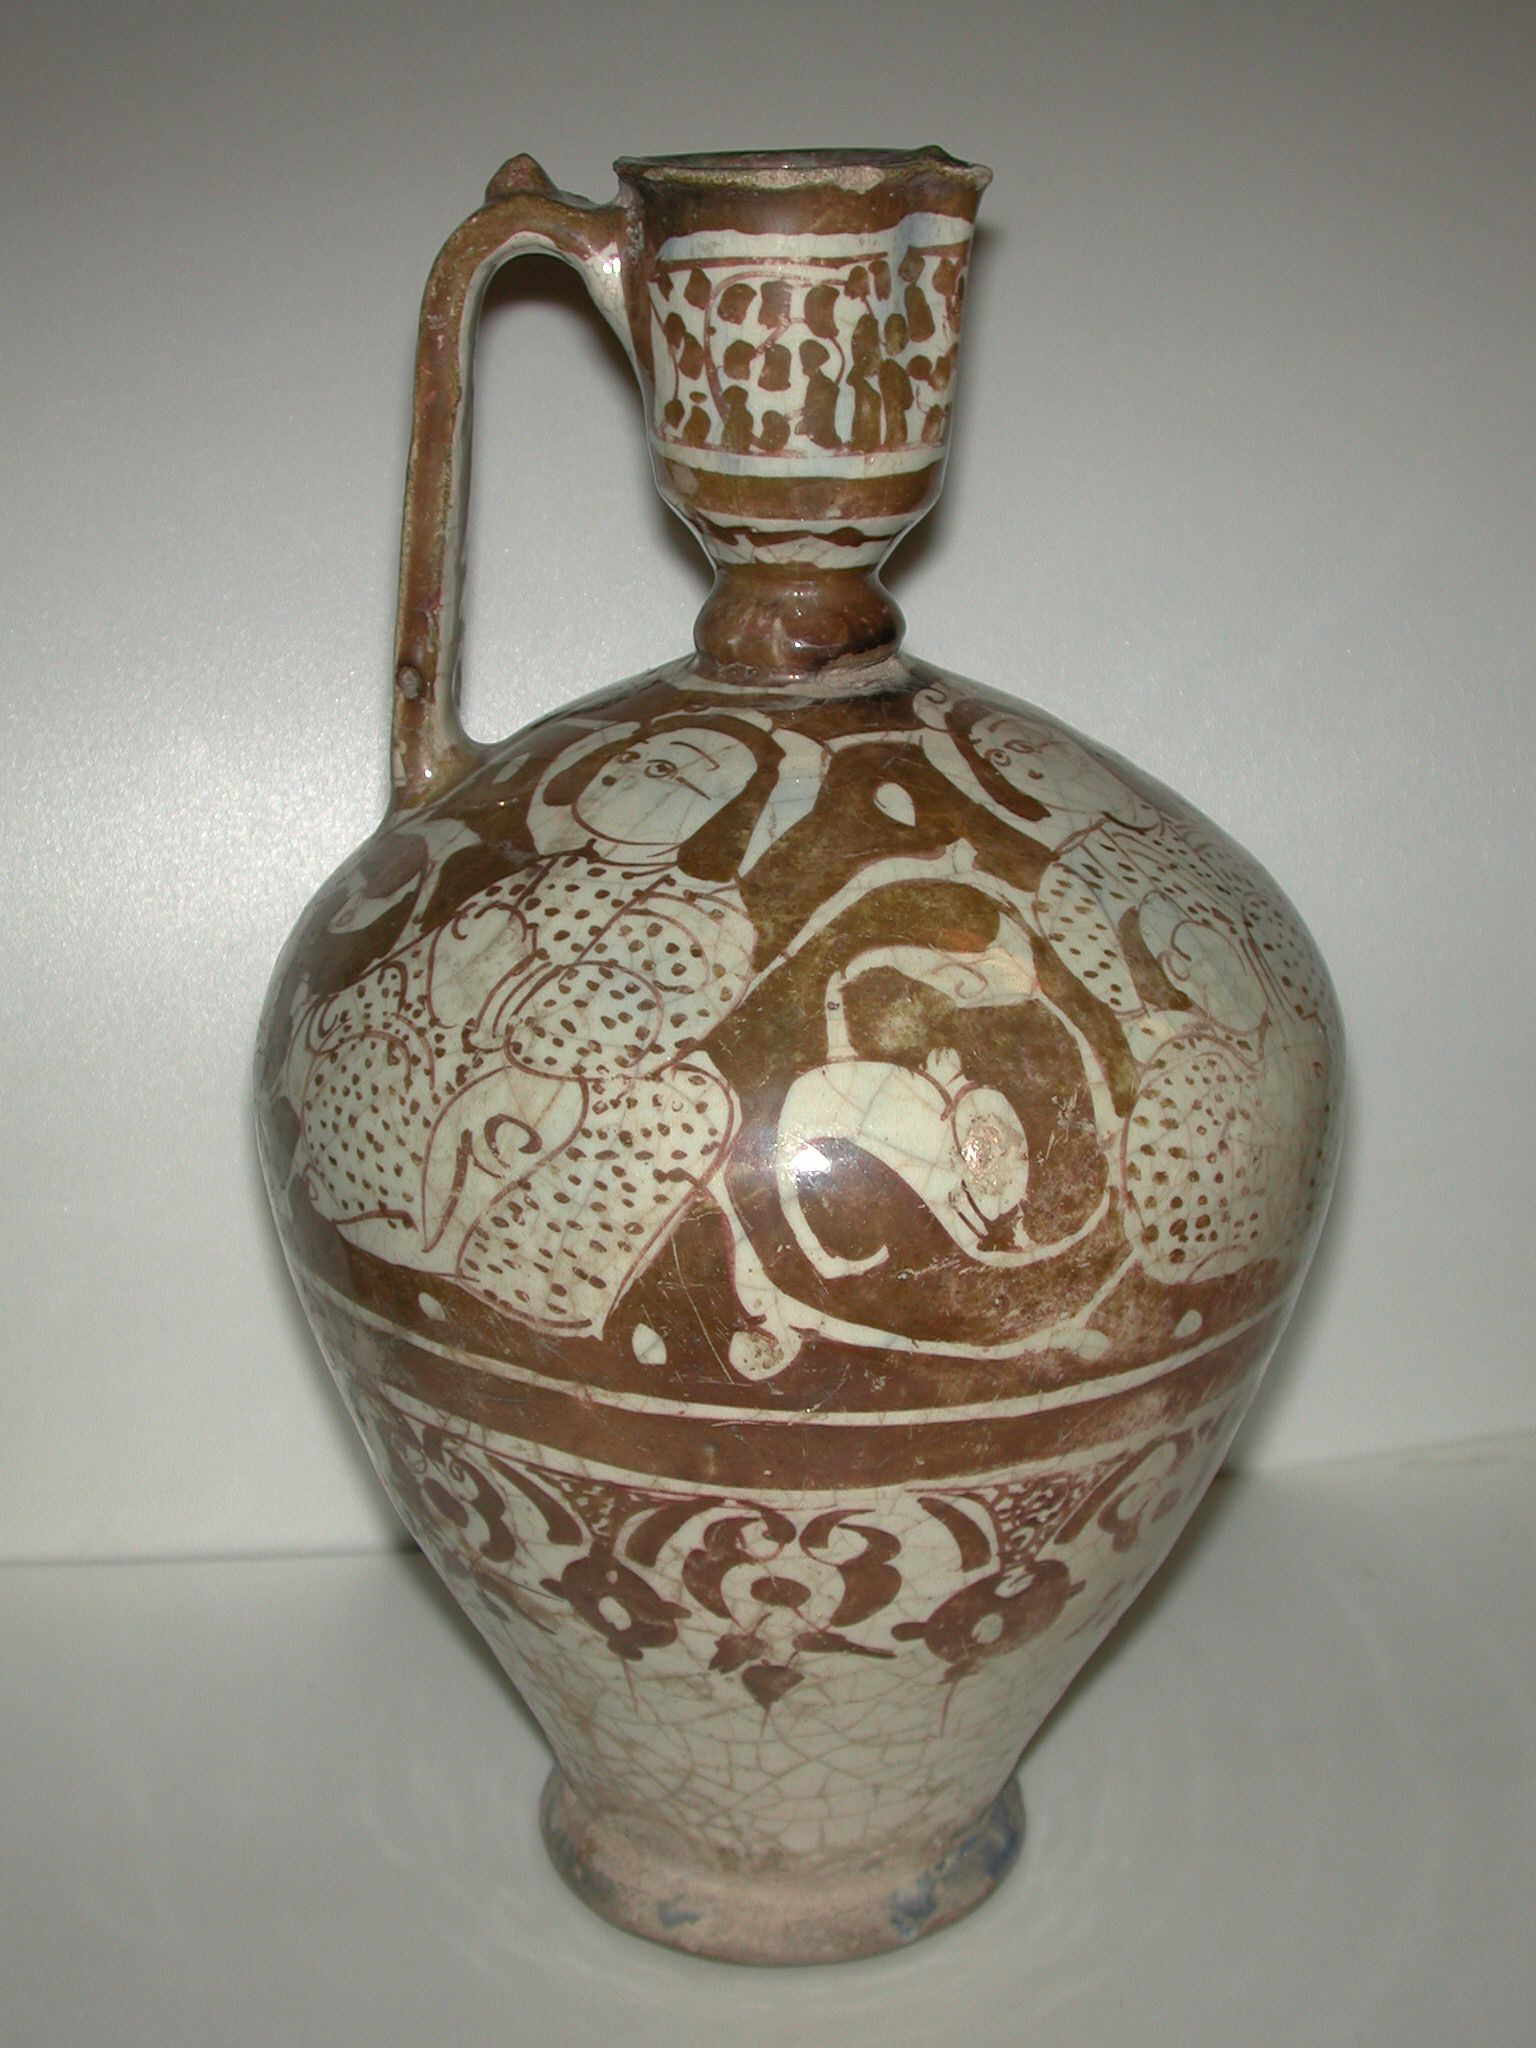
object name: ewer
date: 1101-1300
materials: glaze, stonepaste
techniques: luster painting, molding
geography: iran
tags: women